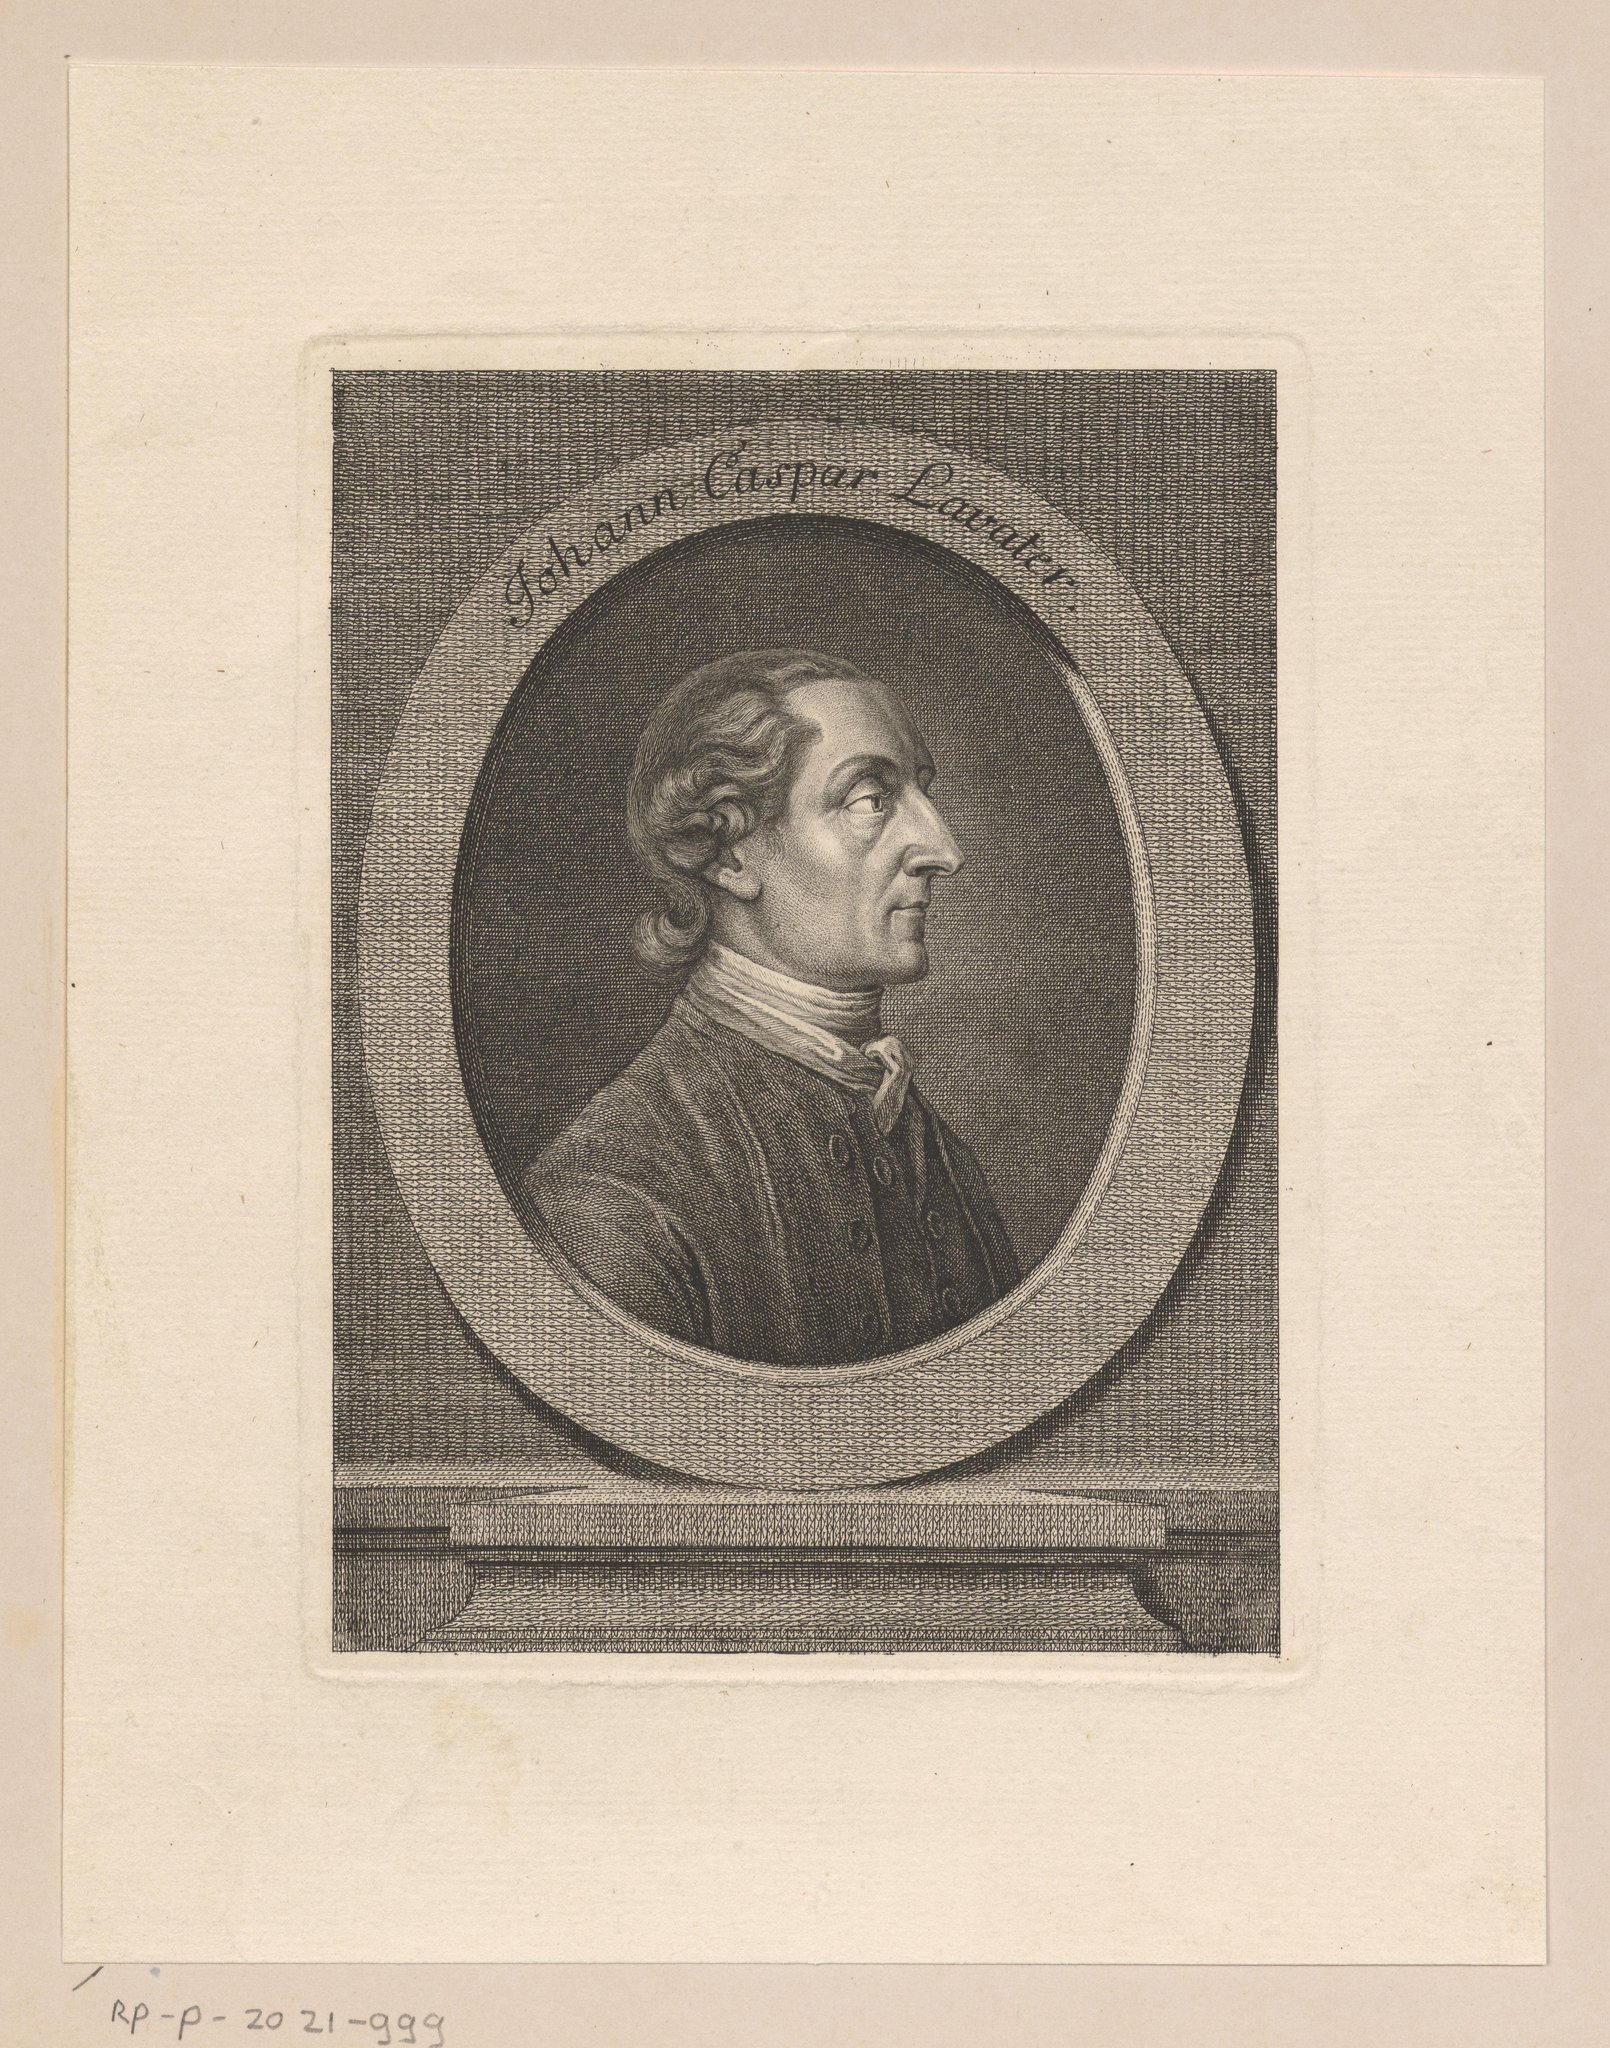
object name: print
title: Portret van Johann Caspar Lavater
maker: Anonymous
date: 1790-1820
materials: paper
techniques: etching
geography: germany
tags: johann caspar lavater, ornament ~ medallion, historical persons, scholar, philosopher (+ portrait of scholar, scientist)